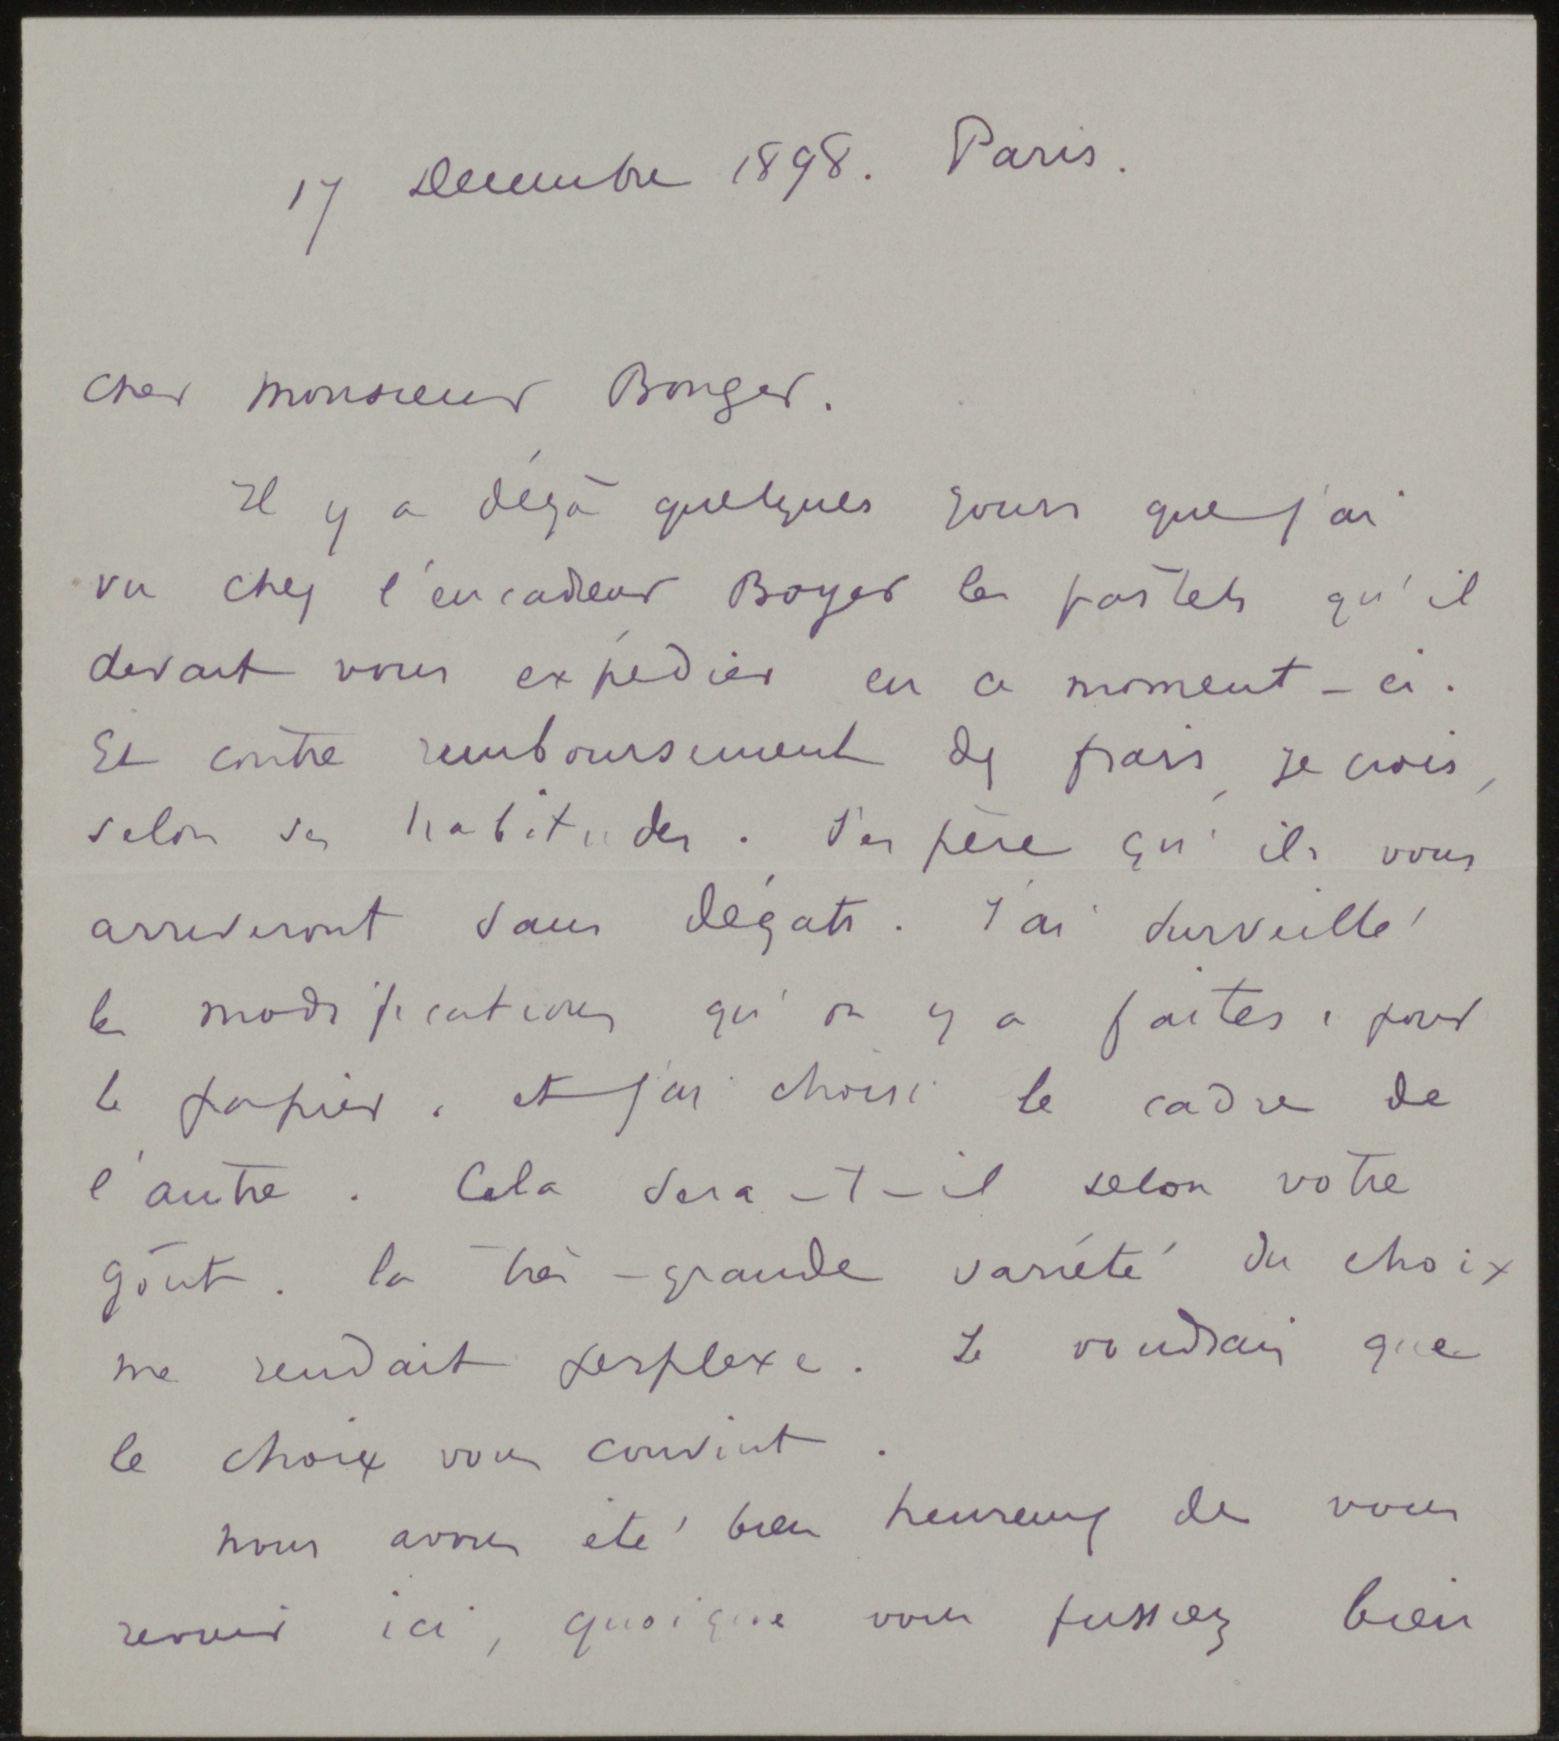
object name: letter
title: Brief aan Andries Bonger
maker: odilon redon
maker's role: draughtsman, painter, print maker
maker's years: 1840-1916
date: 1898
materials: ink, paper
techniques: pen, writing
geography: paris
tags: lille, paris, print maker, émile bernard, amsterdam, andries bonger, drawing, exhibition ~ art